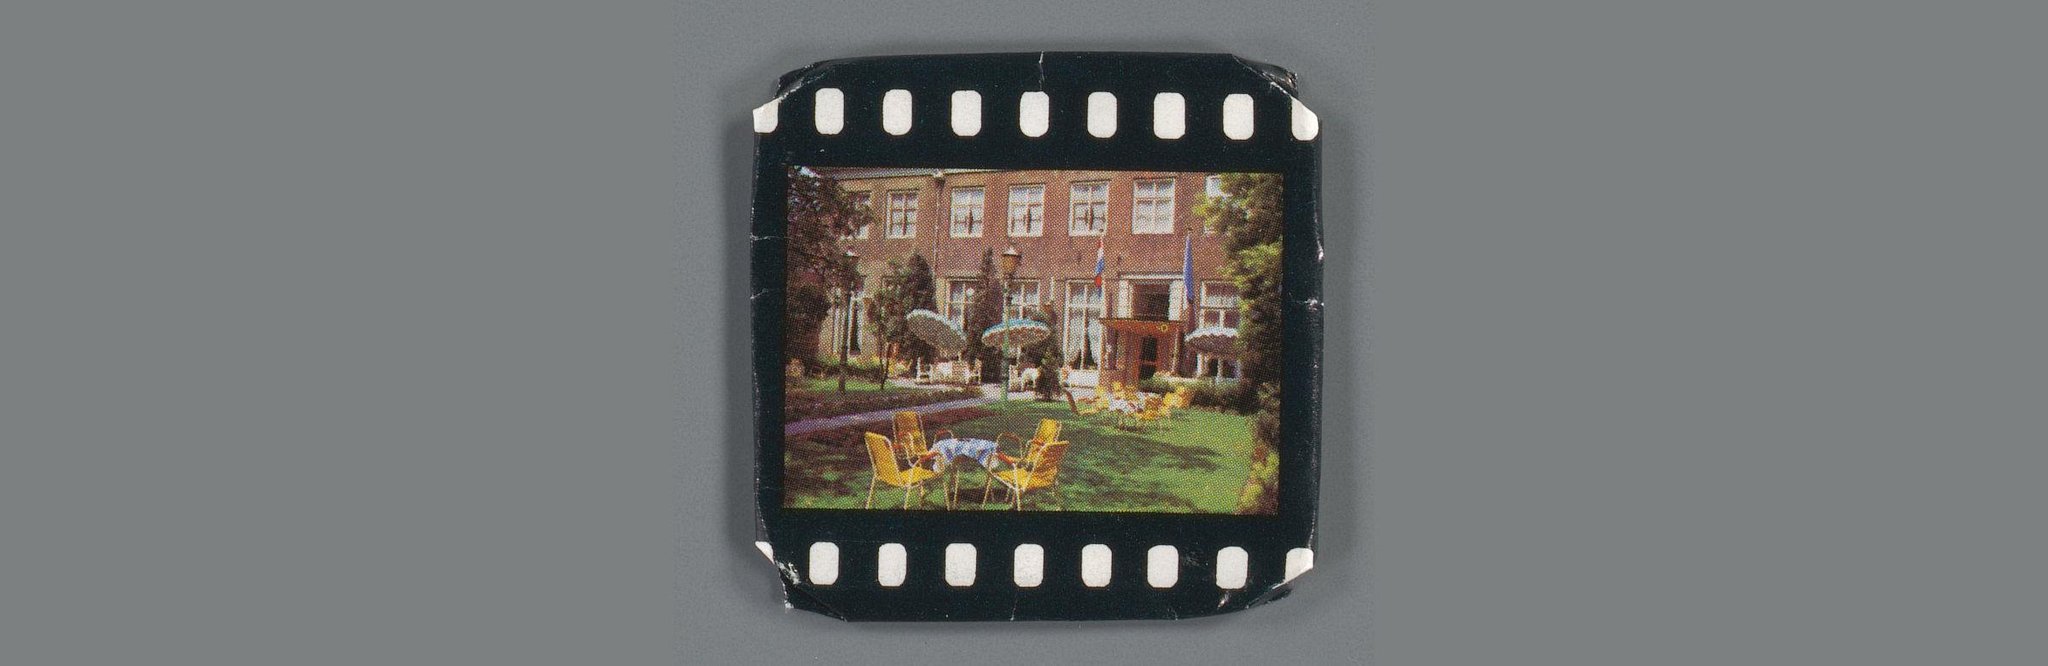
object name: wrapper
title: Wikkel in de vorm van een filmstrip, met een voorstelling van het terras van hotel-restaurant 's-Gravenhof te Zutphen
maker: Anonymous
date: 1950-1980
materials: paper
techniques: offset printed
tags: pavement, terrace in front of inn or restaurant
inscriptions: inscription: ‘Hotel-Restaurant/ 's-Gravenhof/ Zutphen/ tel.: 05750-3917’